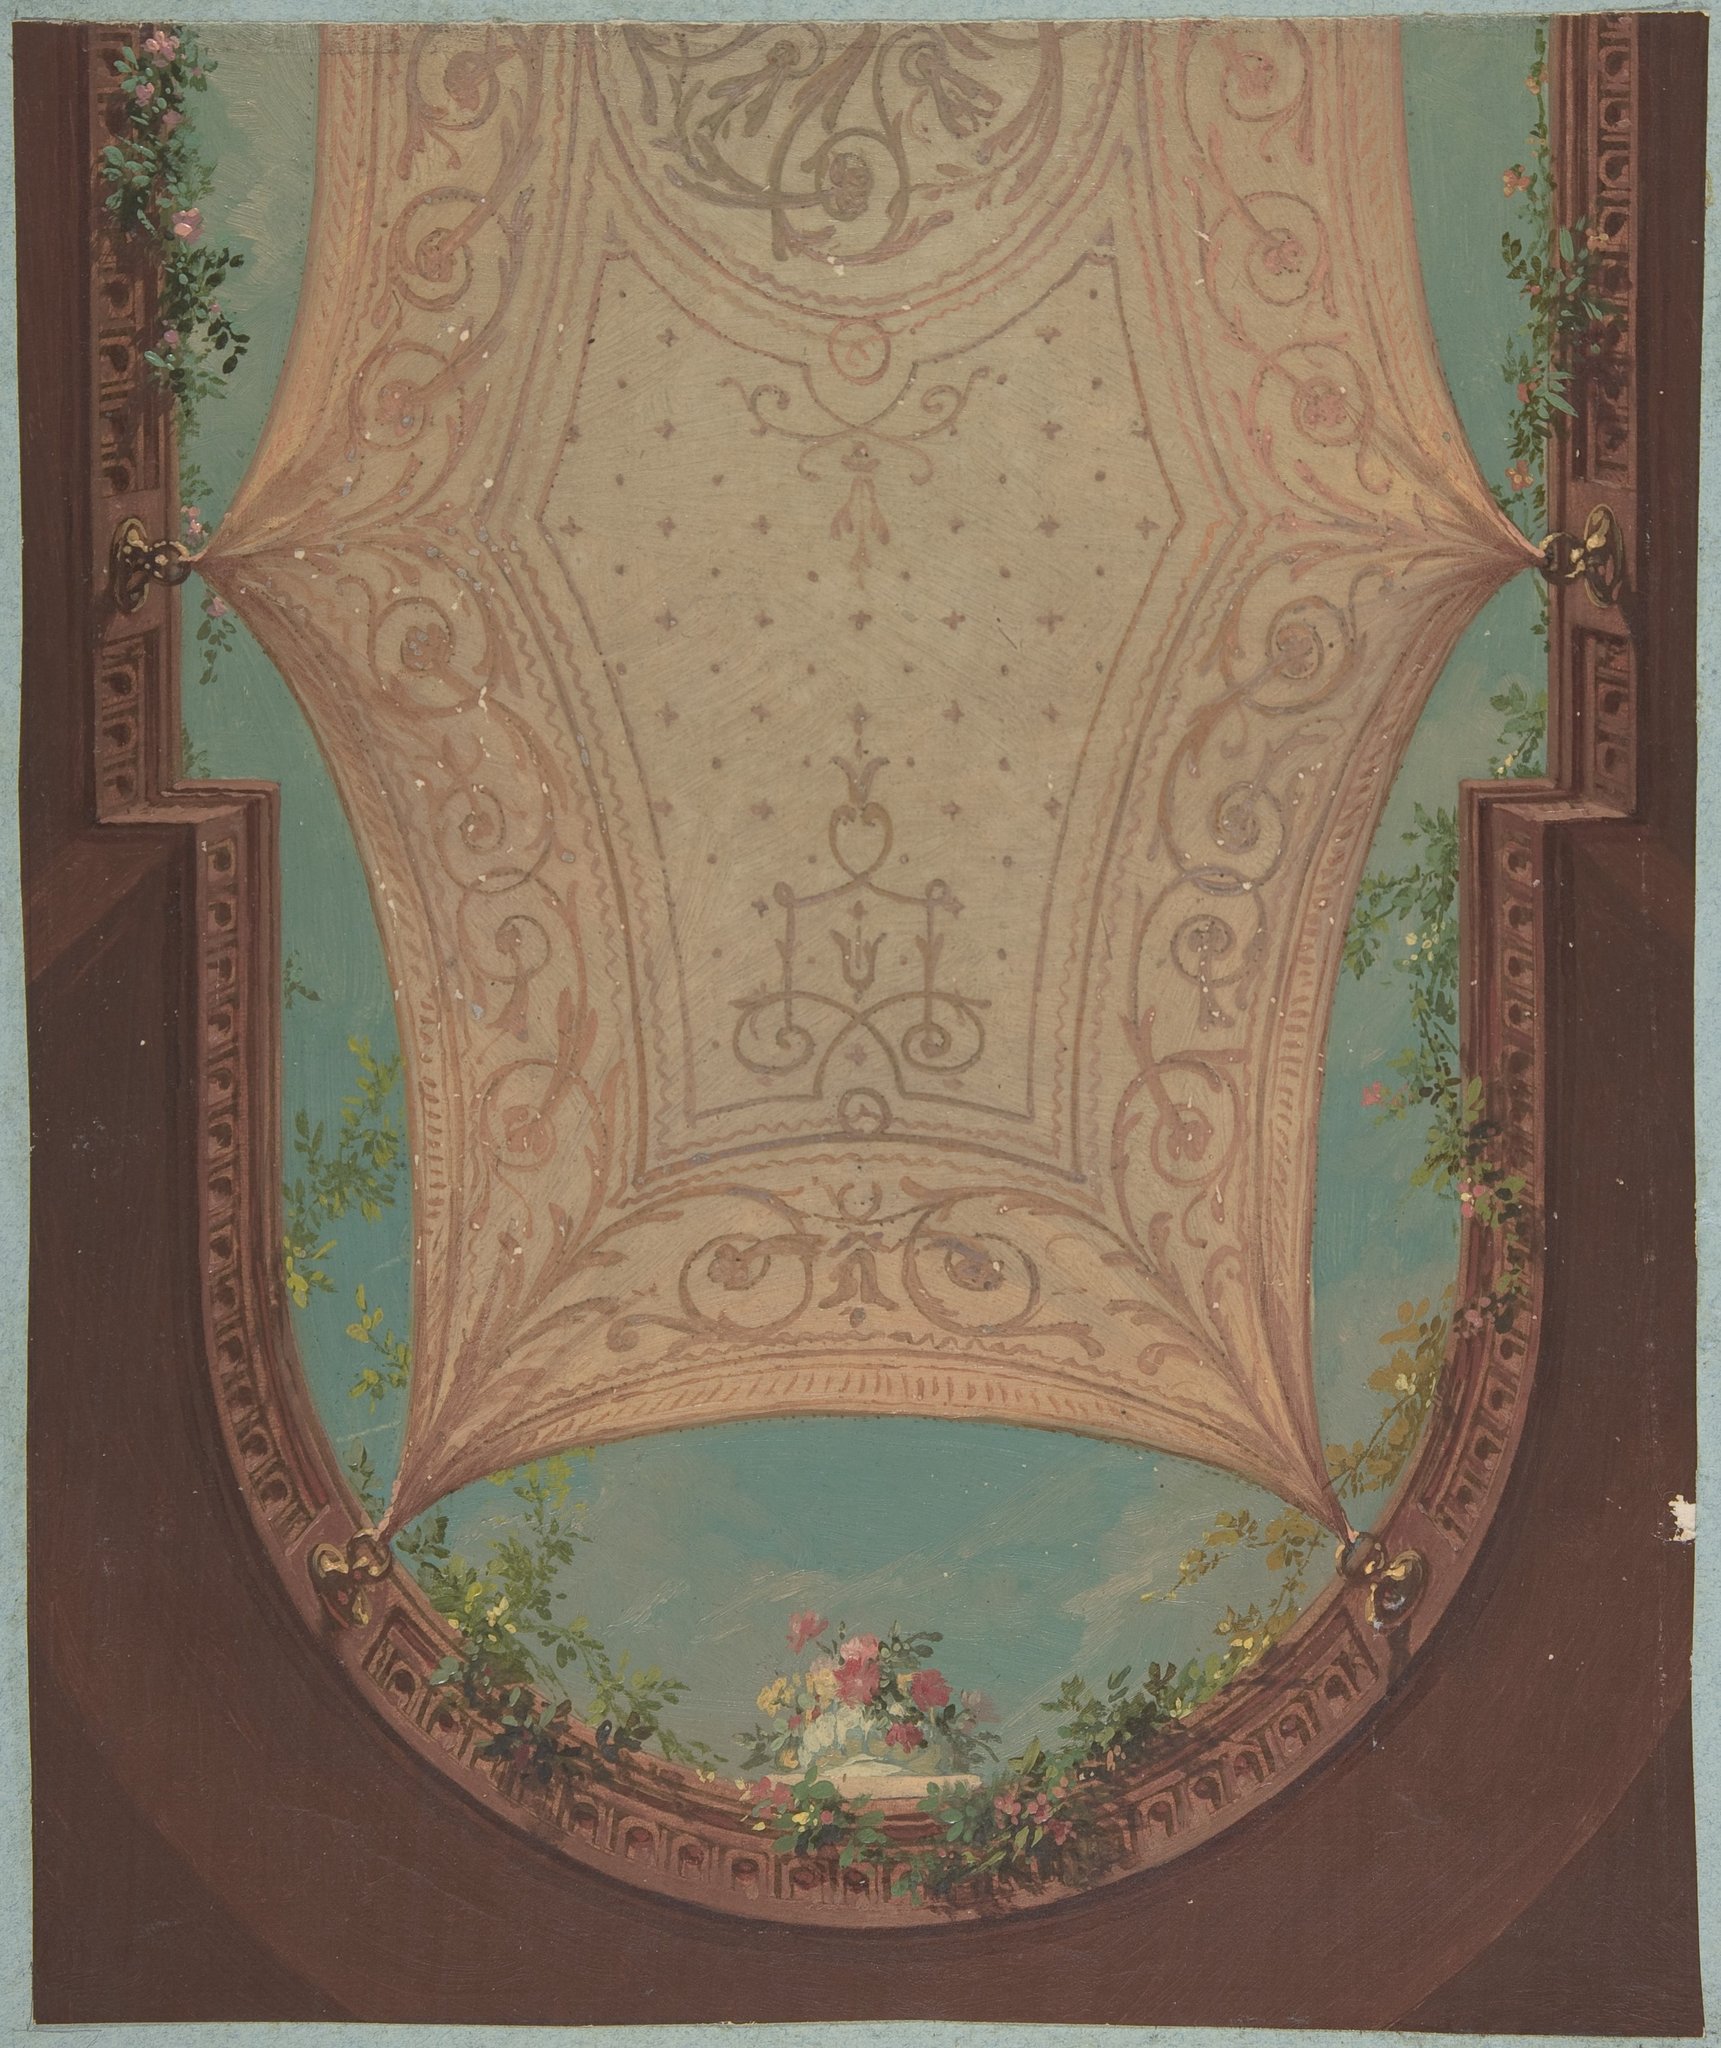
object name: drawing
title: Design for Gallery Ceiling, Hôtel Cottier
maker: jules-edmond-charles lachaise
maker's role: artist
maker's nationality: french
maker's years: 1897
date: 1879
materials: oil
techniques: brush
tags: ceilings